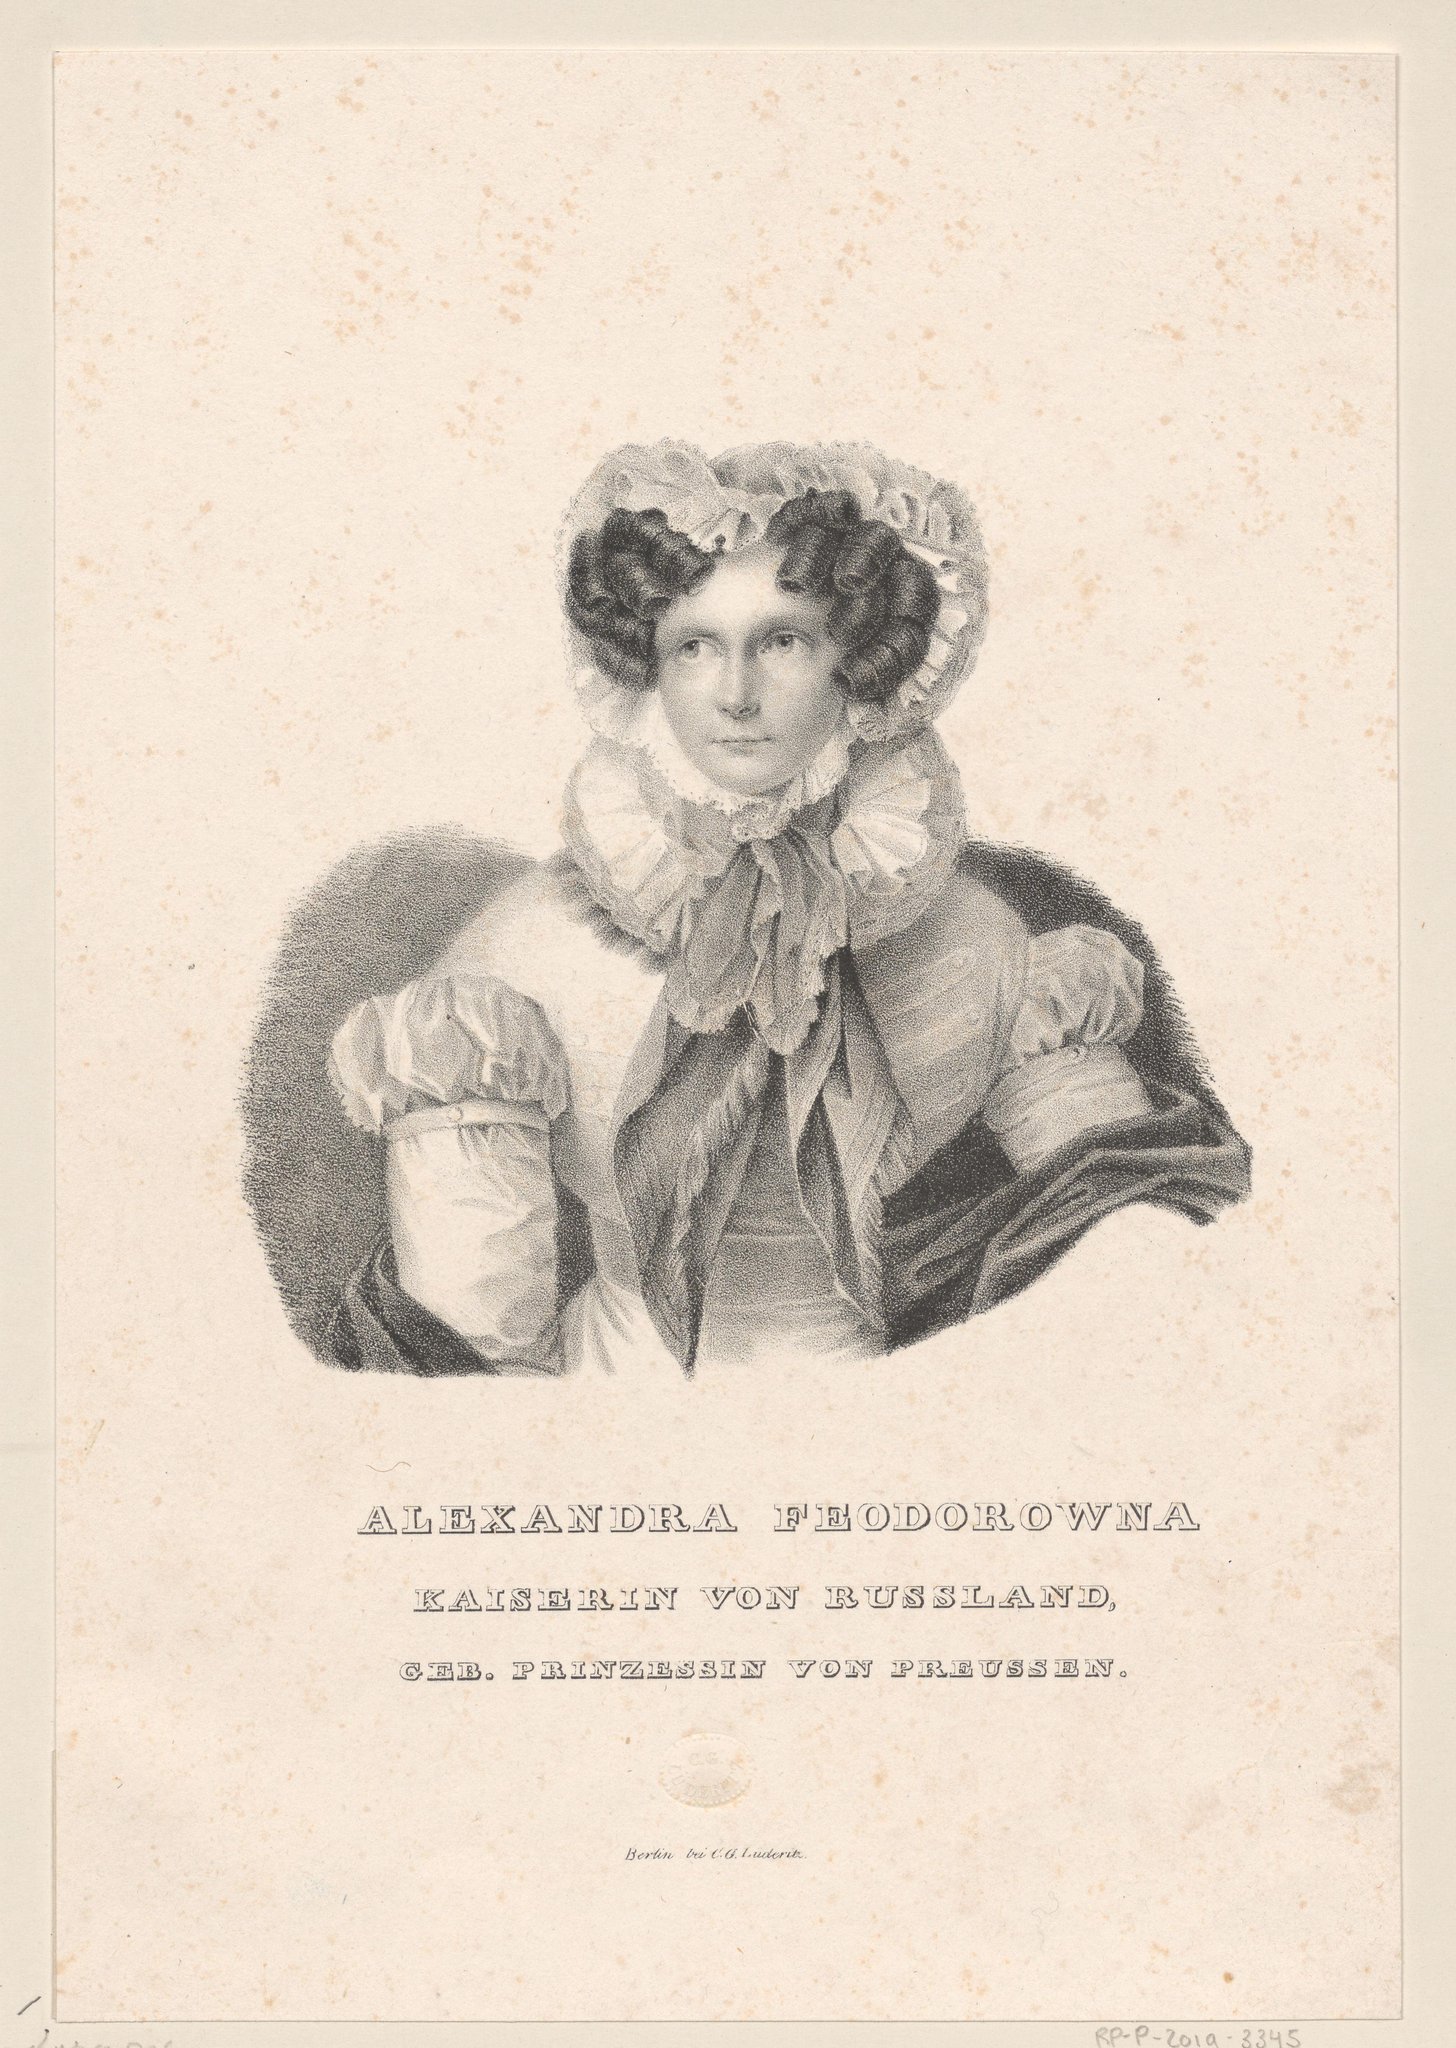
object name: print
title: Portret van Alexandra Fjodorovna, tsarina van Rusland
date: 1830-1860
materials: paper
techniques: lithograph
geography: berlin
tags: berlin, historical persons - bb - woman, emperor - bb - female ruler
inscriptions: workshop stamp: Lugt 4519